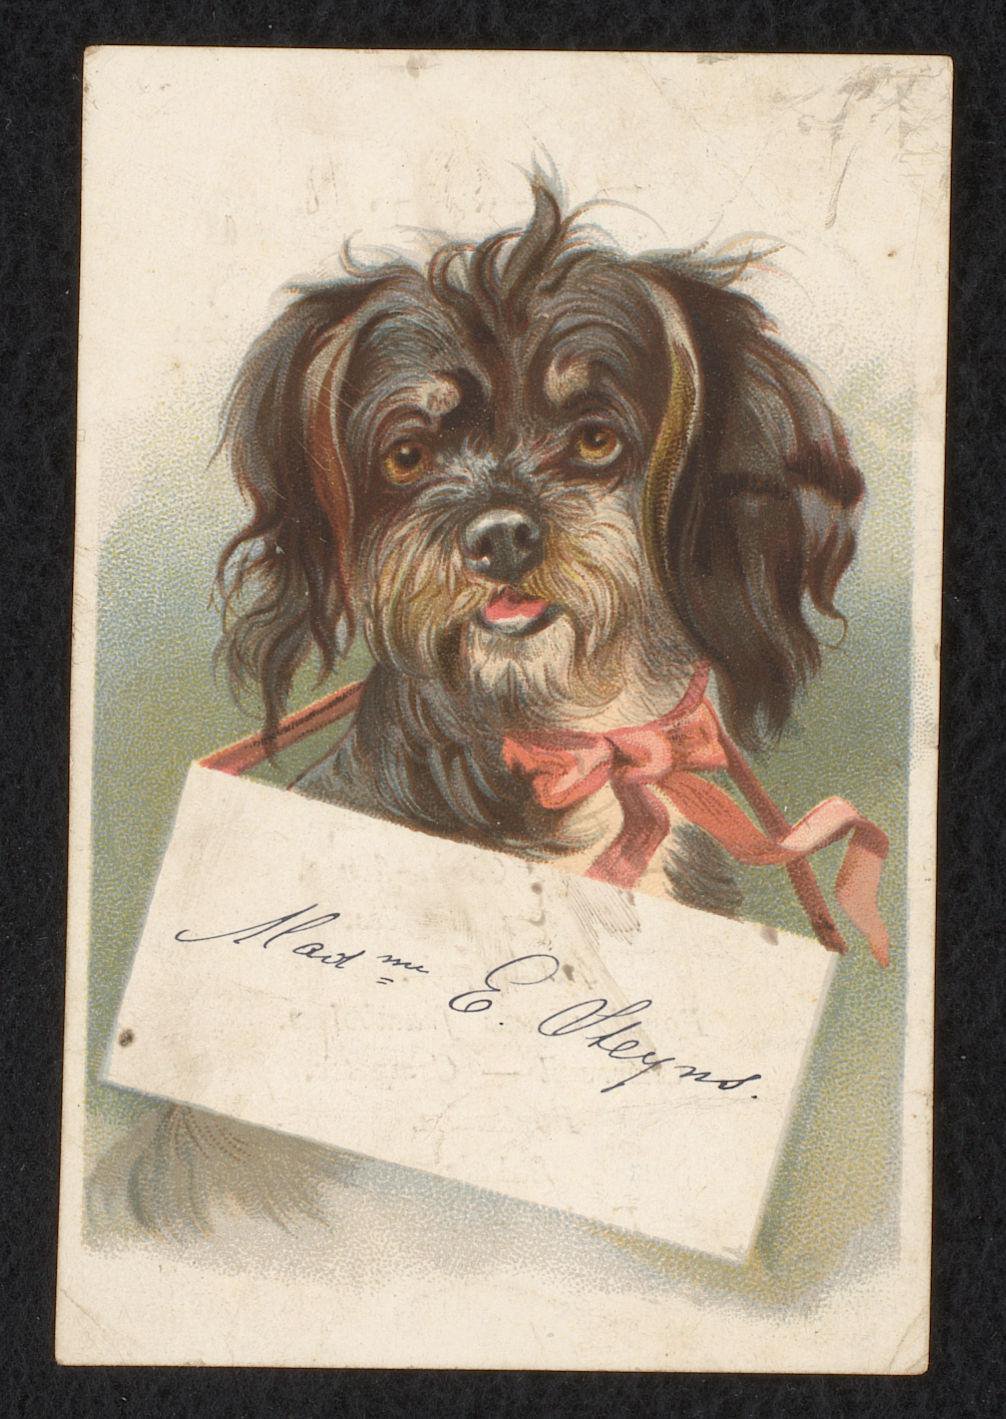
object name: print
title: Menu van het diner ter ere van de eerste heilige communie van Clara Steyns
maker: Anonymous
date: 1882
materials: paper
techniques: chromolithography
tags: first communion, dog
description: Op de voorzijde een hondenkop met een bord om de nek. Op dat bord is in handschrift 'Madme. E. Steyns' geschreven. Op de achterzijde het menu van het diner op 26 maart 1882.